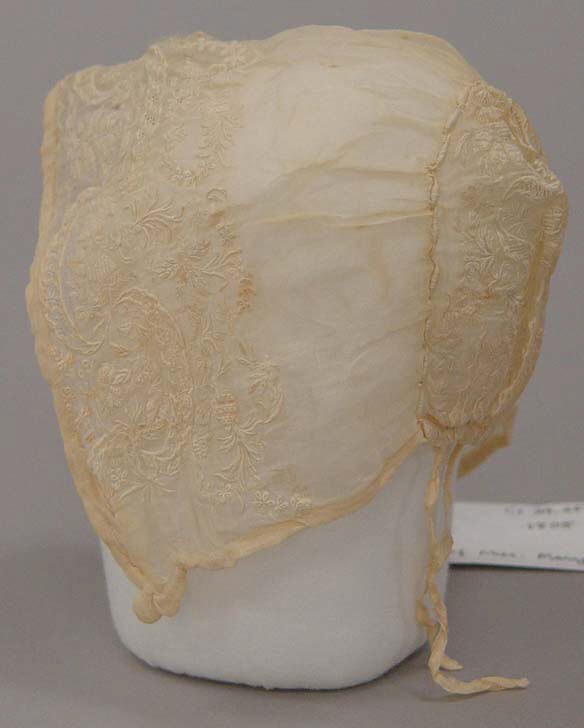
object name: cap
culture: american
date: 1805